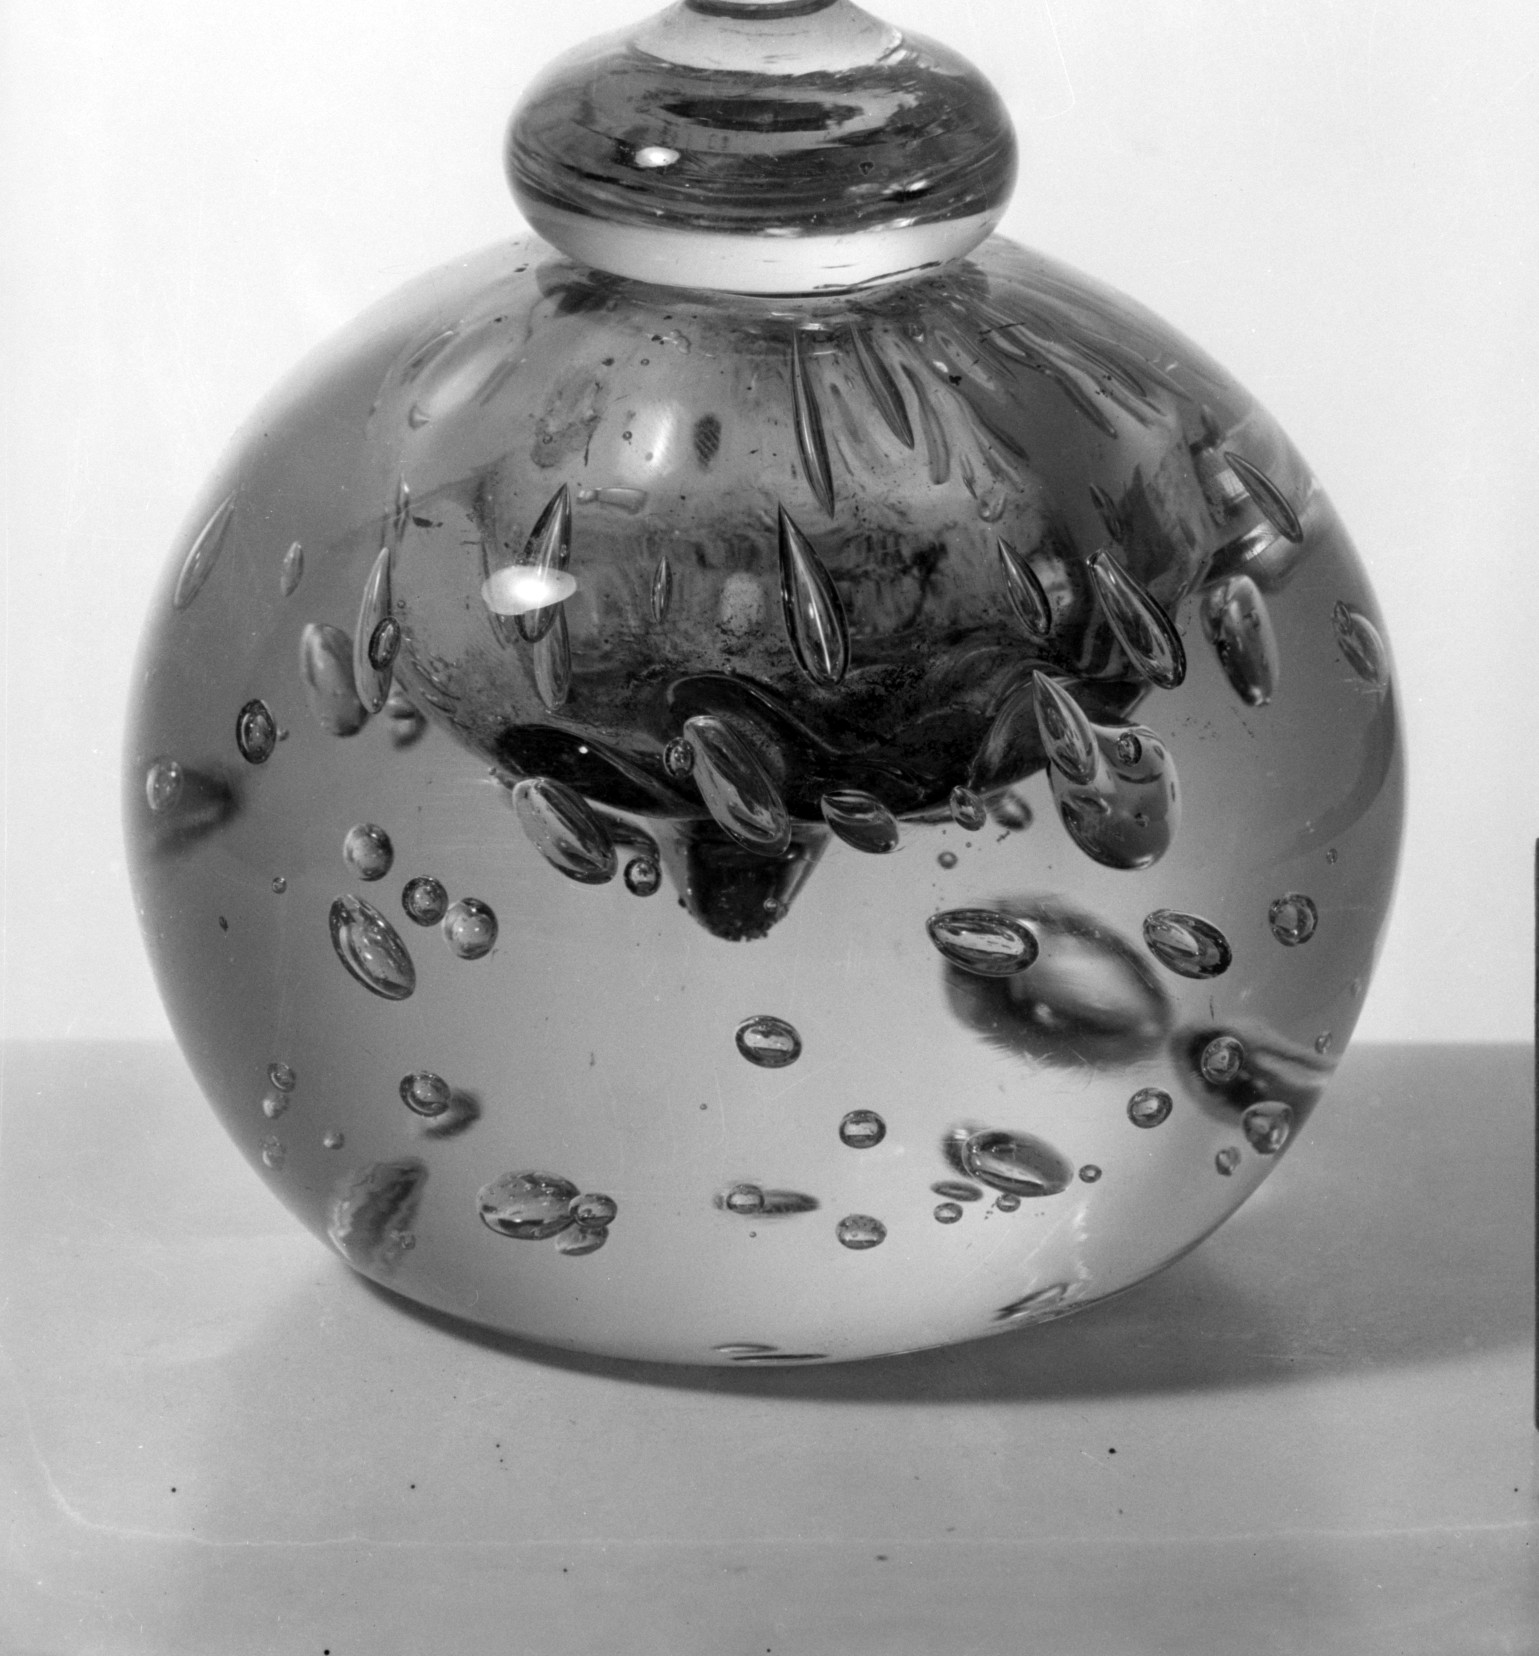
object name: inkwell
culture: british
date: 1850-1900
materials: gemstone, glass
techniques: glassblowing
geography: england